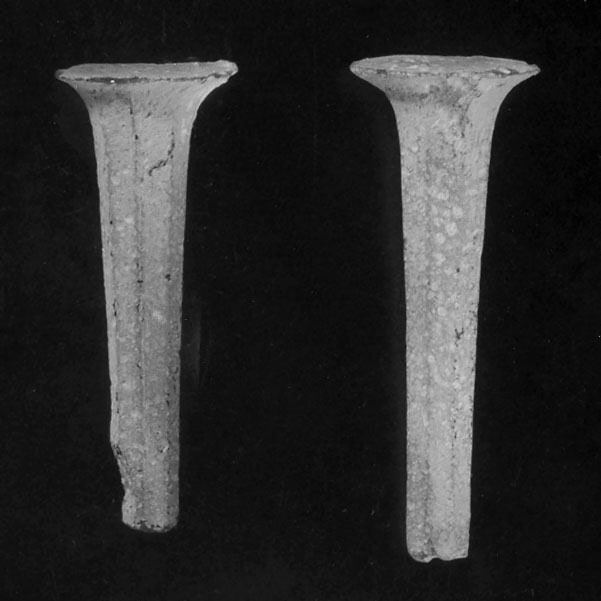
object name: plug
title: Pair of Turquoise-Blue Plugs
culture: chinese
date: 300-201 BCE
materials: gilt, glass